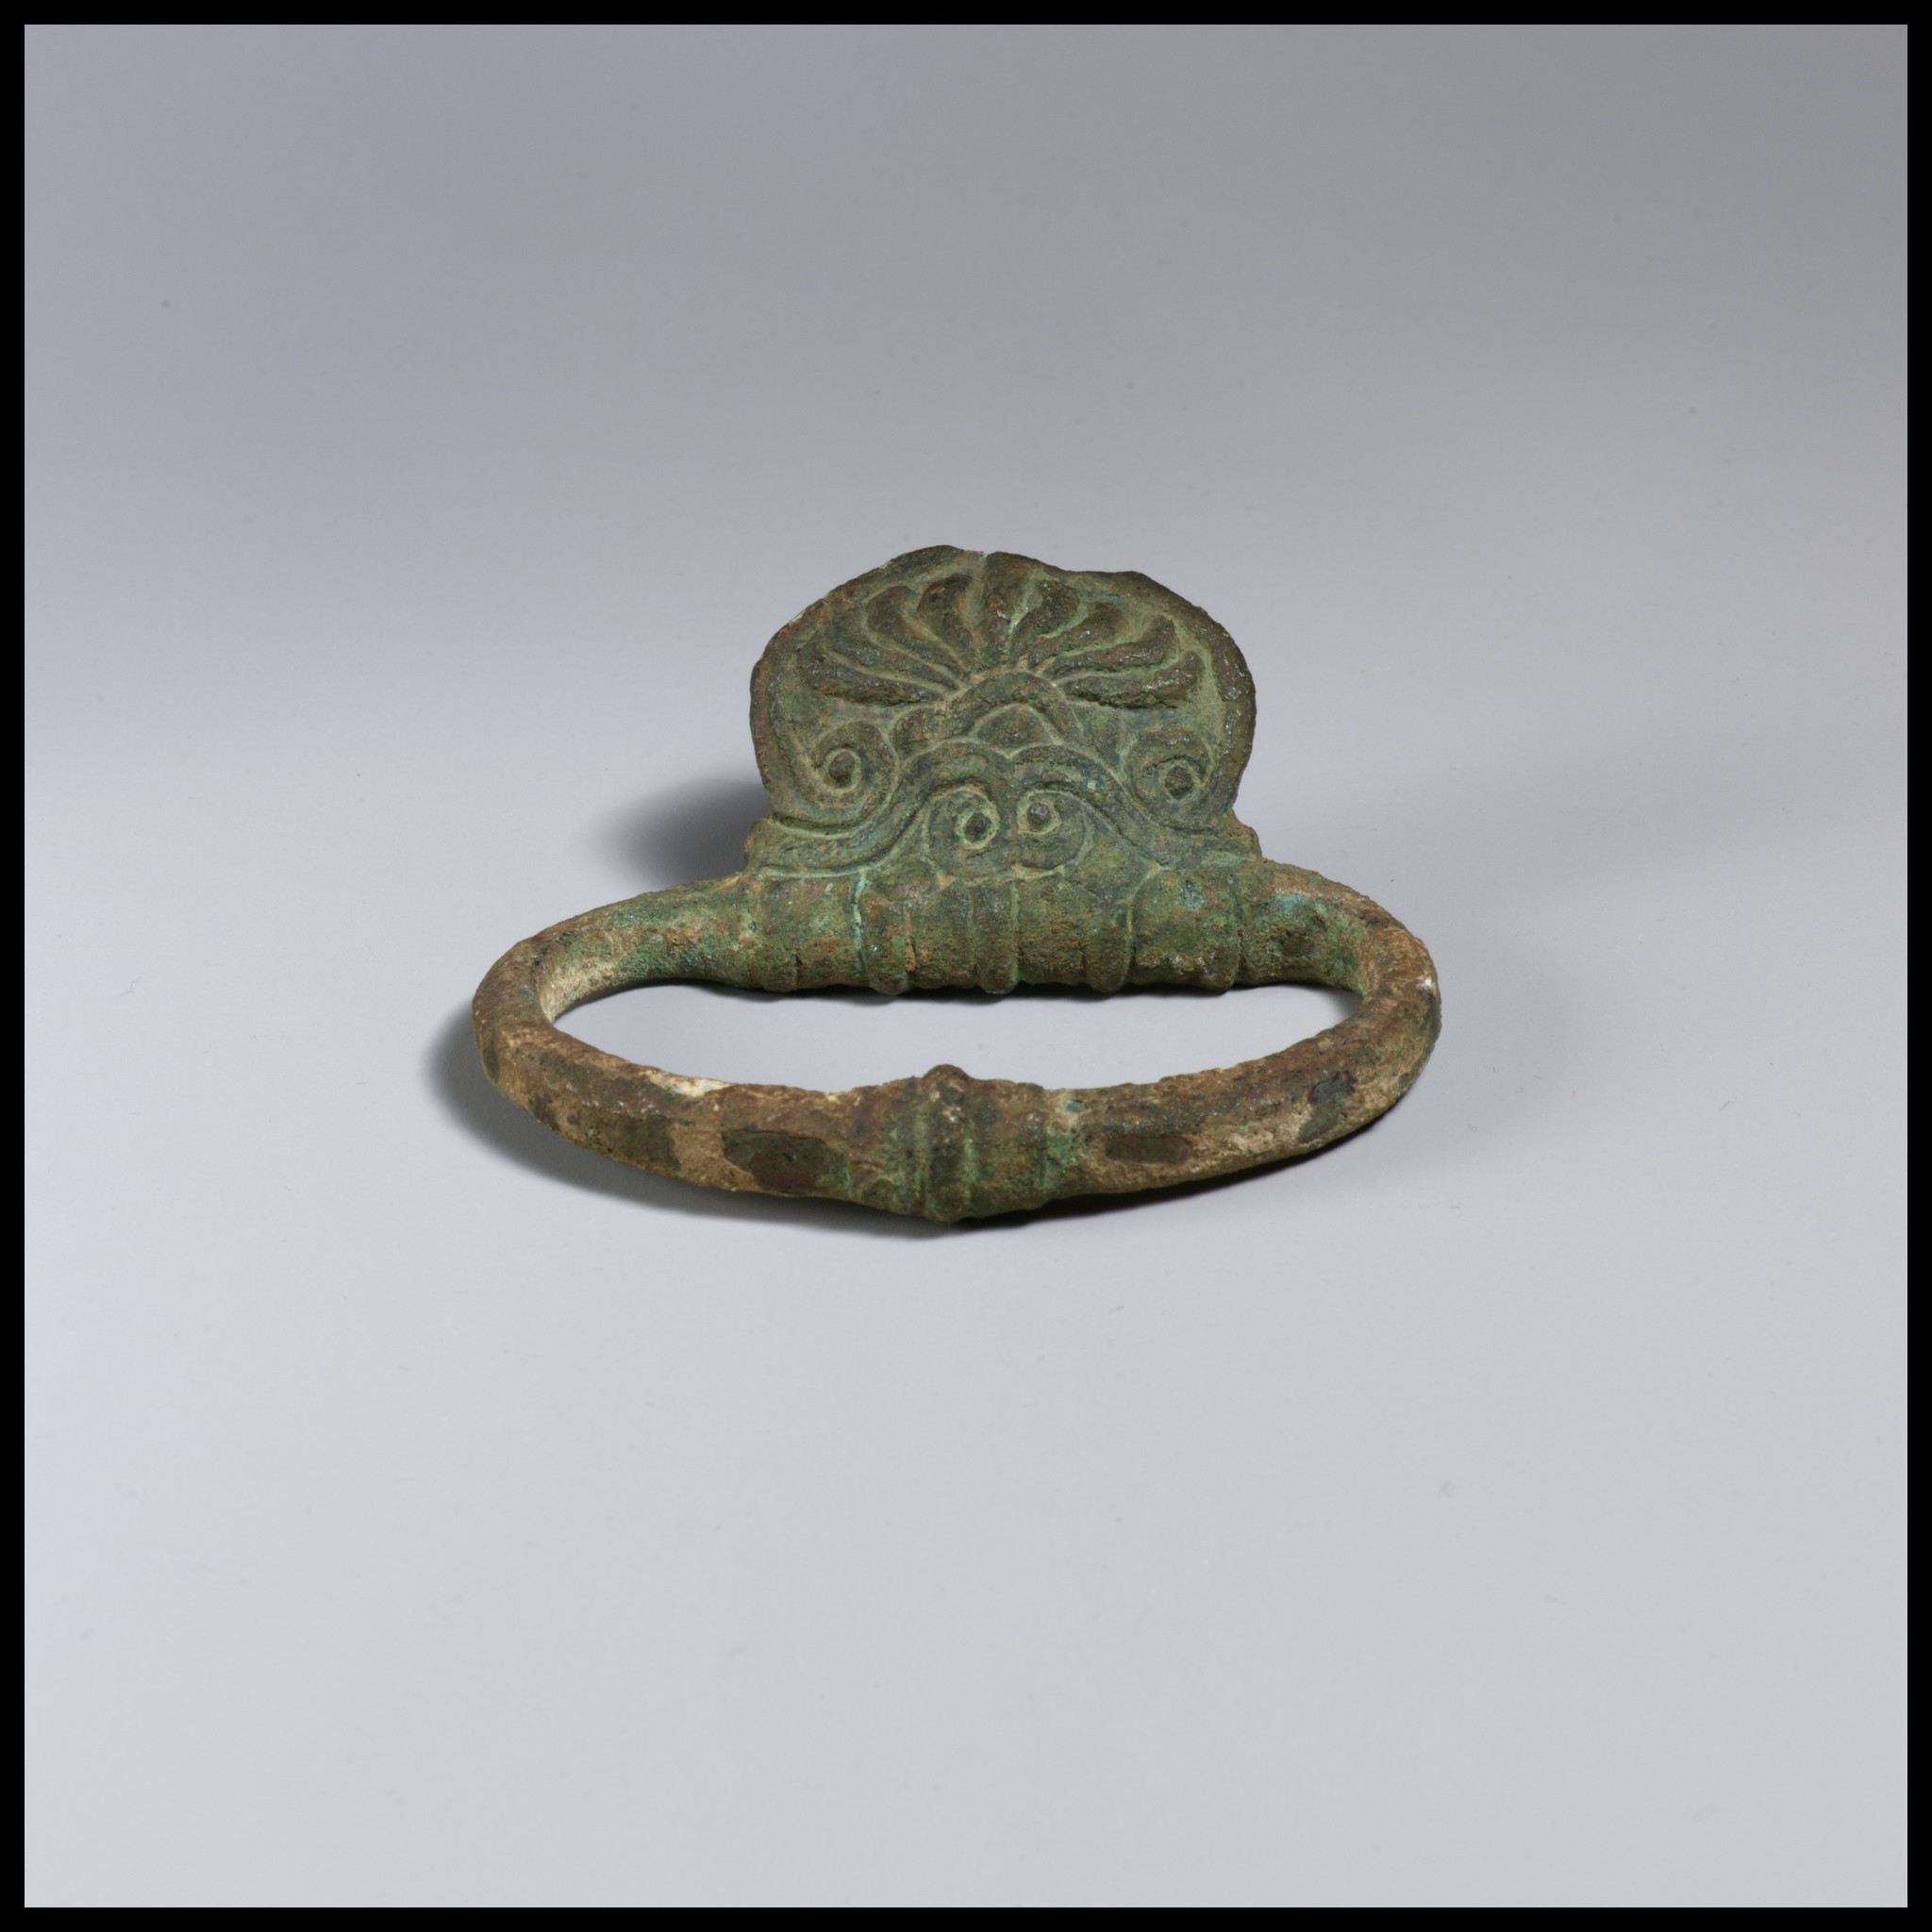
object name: handle of a bowl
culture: roman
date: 670 BCE-330 CE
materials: bronze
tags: palmettes